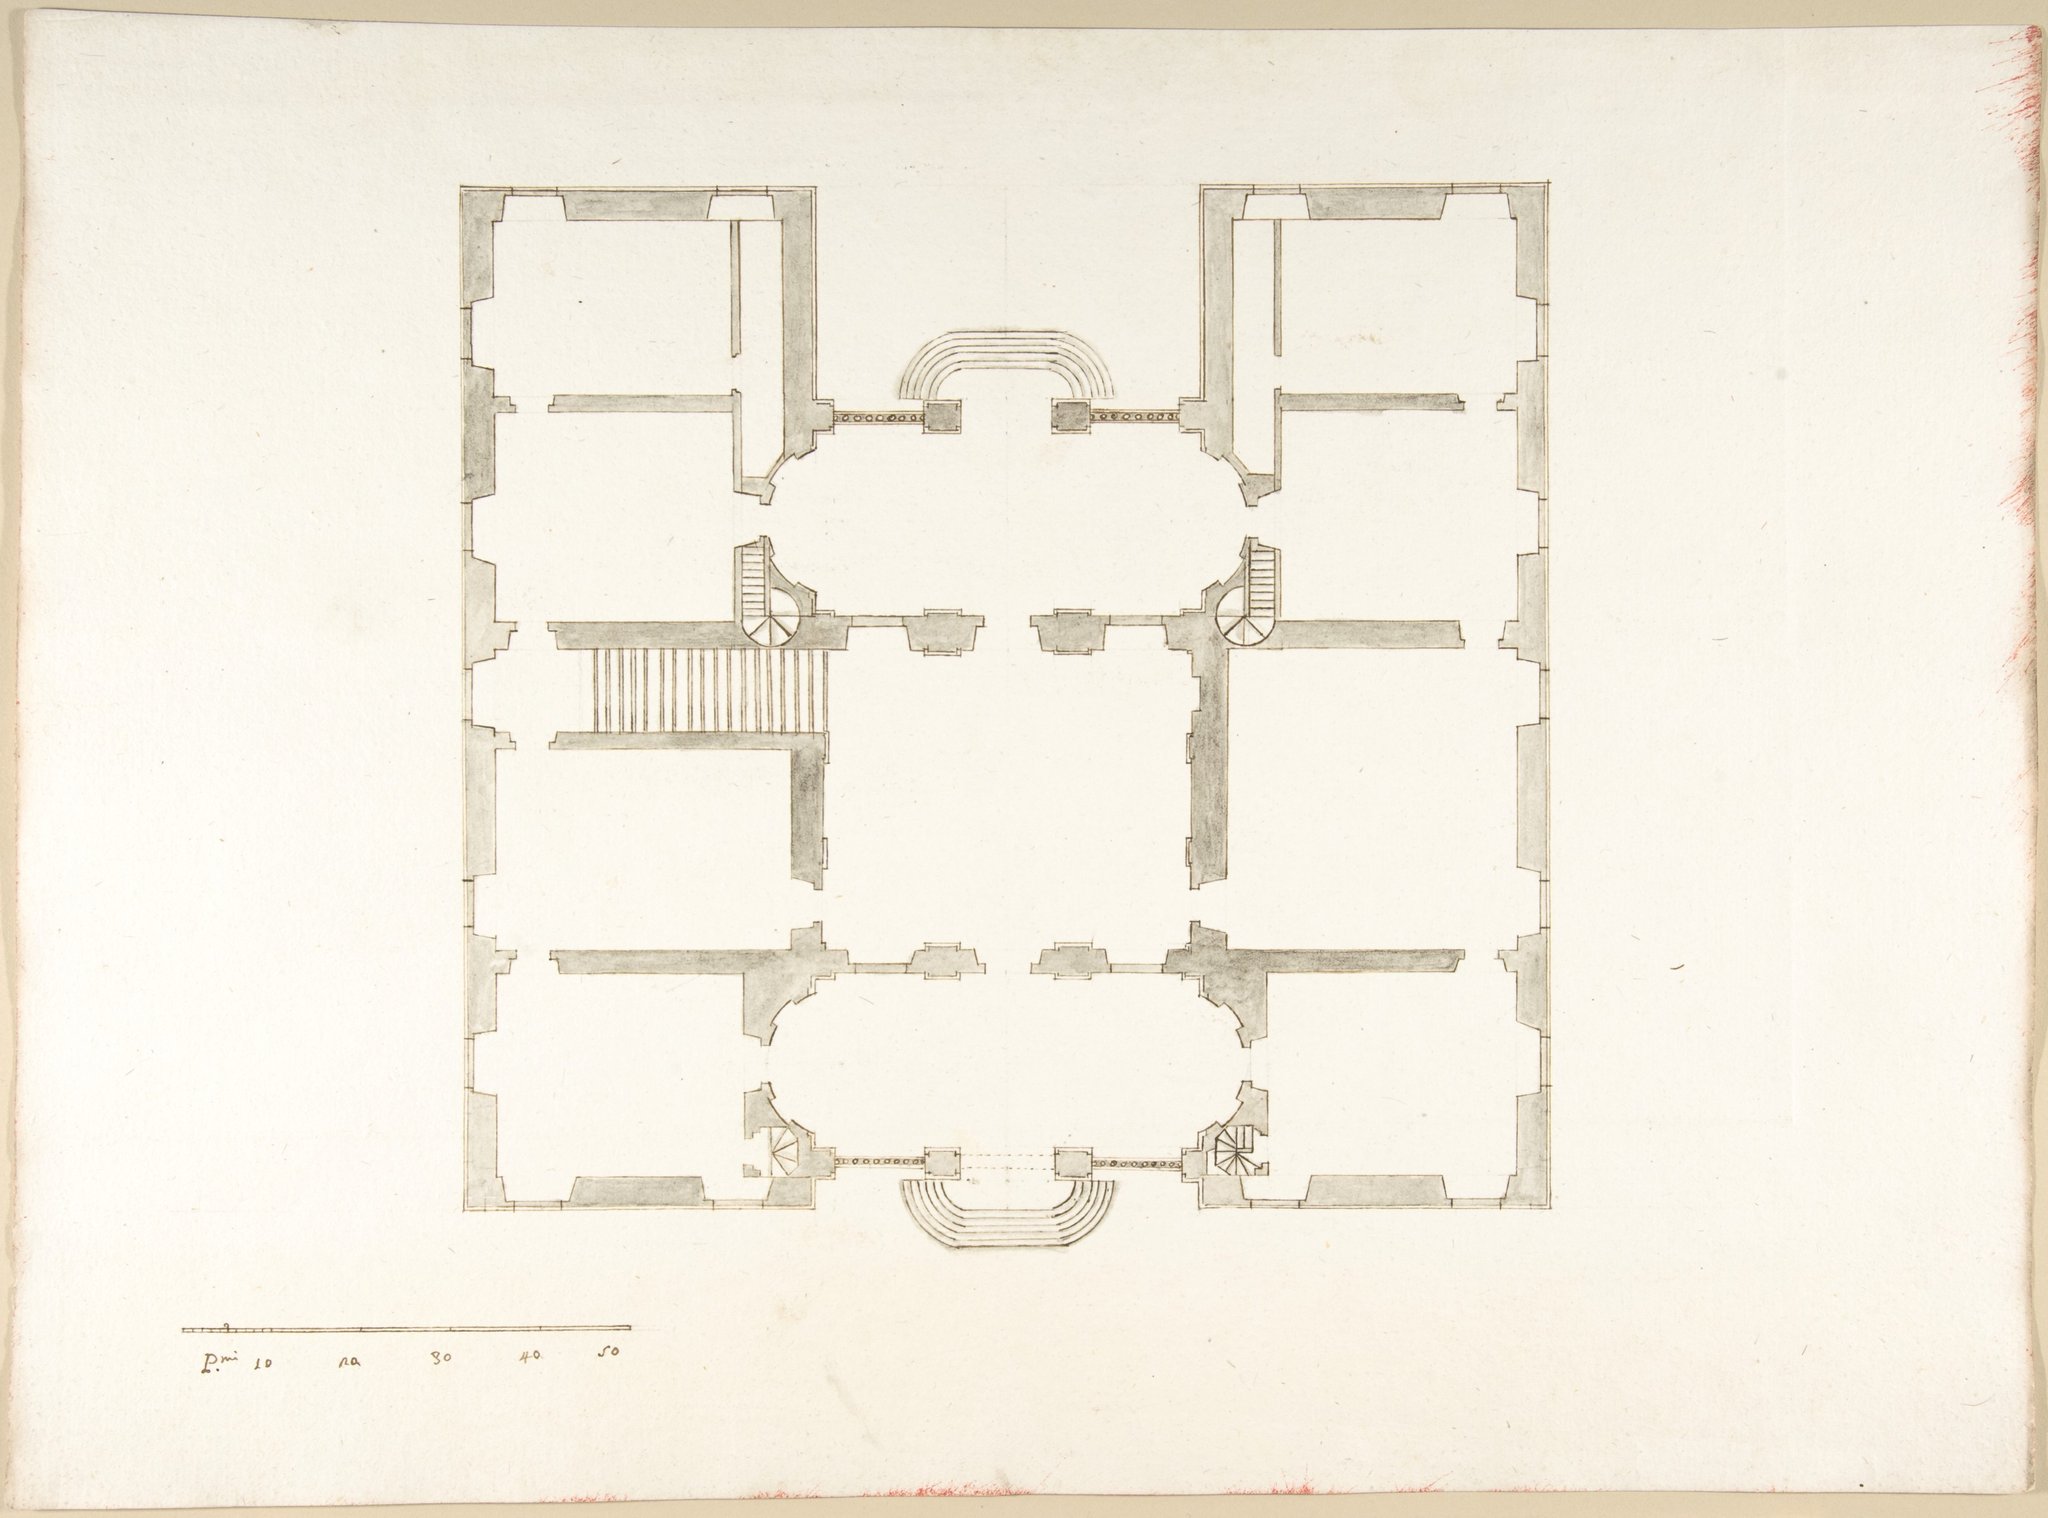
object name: drawing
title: Plan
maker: pietro paolo coccetti (cocchetti)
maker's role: artist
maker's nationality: italian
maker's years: 1710-1727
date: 1710-1727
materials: graphite, ink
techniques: brush, pen, wash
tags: architecture